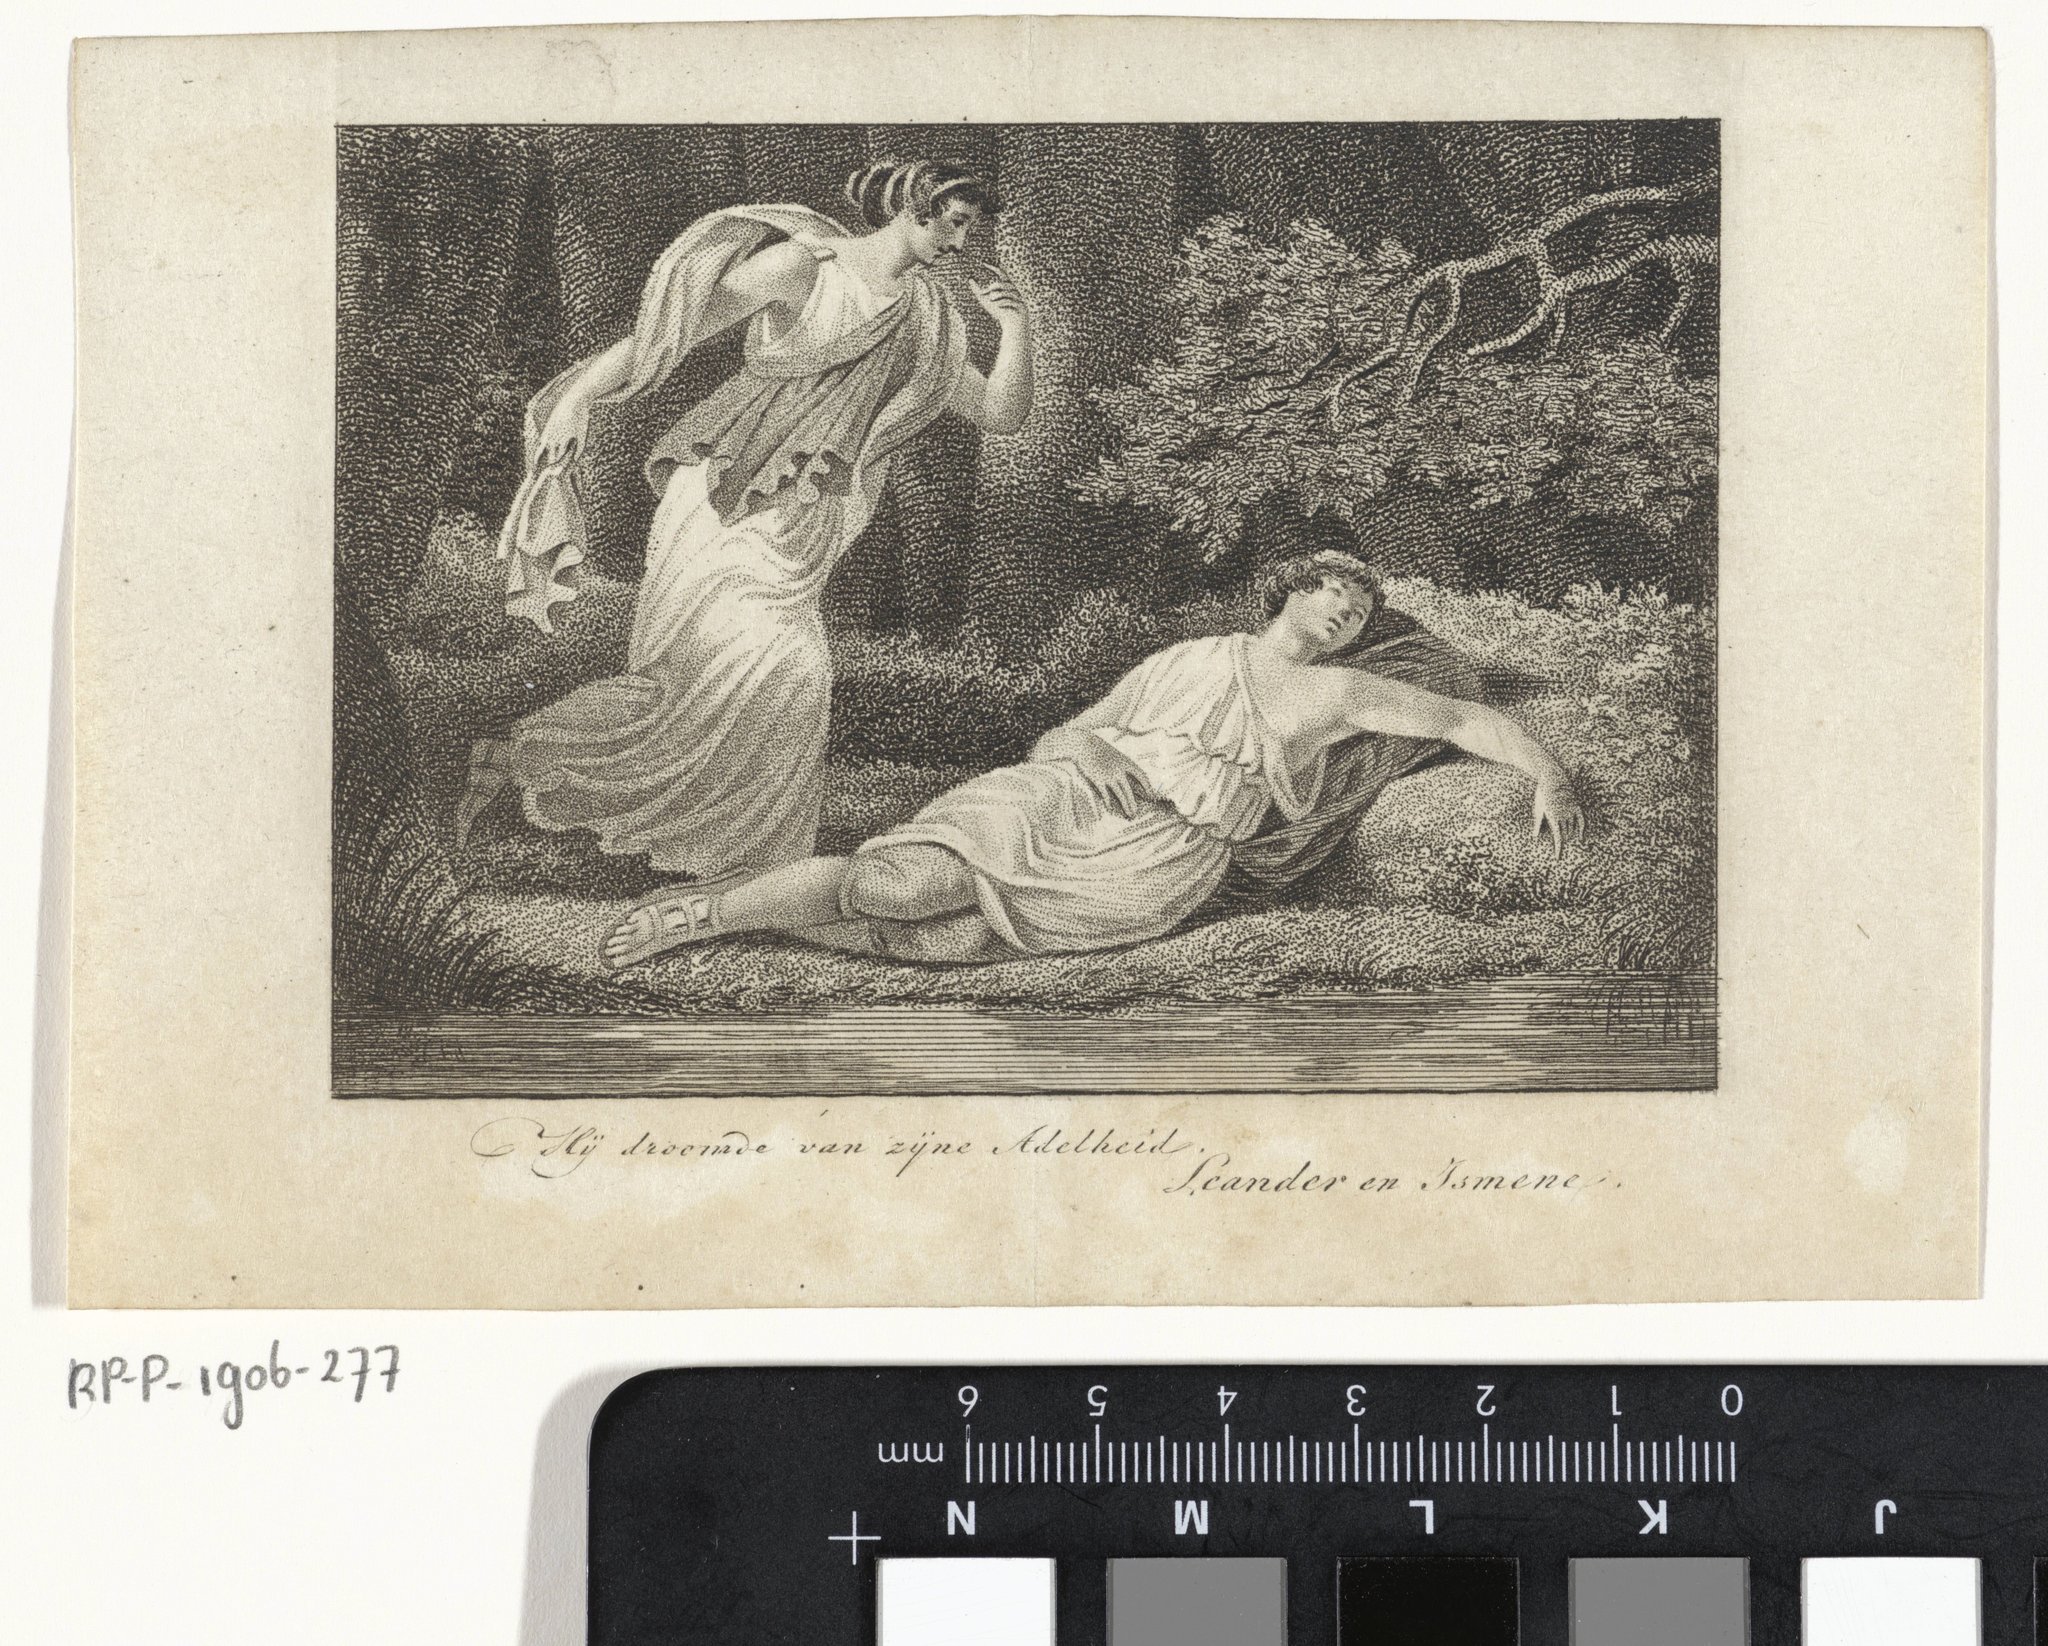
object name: book illustration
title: Leander en Ismene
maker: ludwig gottlieb portman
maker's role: print maker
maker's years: 1772-1828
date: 1803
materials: paper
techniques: etching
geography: amsterdam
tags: watching the beloved asleep, specific works of literature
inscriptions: collector's mark: Lugt 2228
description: Landschap met Leander die langs de oever van een rivier in slaap is gevallen. Vanuit het bos rent Ismene naar hem toe. Illustratie van een scène uit 'Leander en Ismene'.